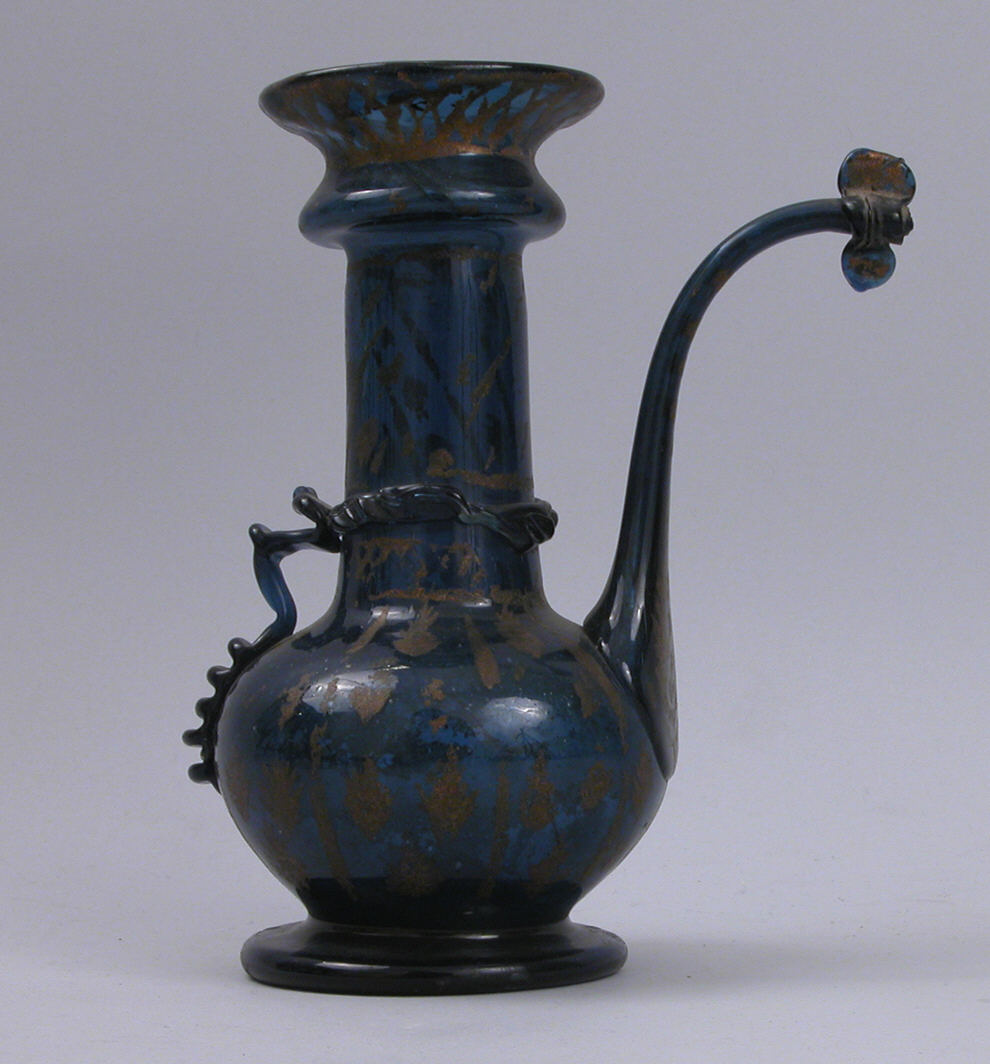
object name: ewer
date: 1701-1900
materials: glass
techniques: molding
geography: iran